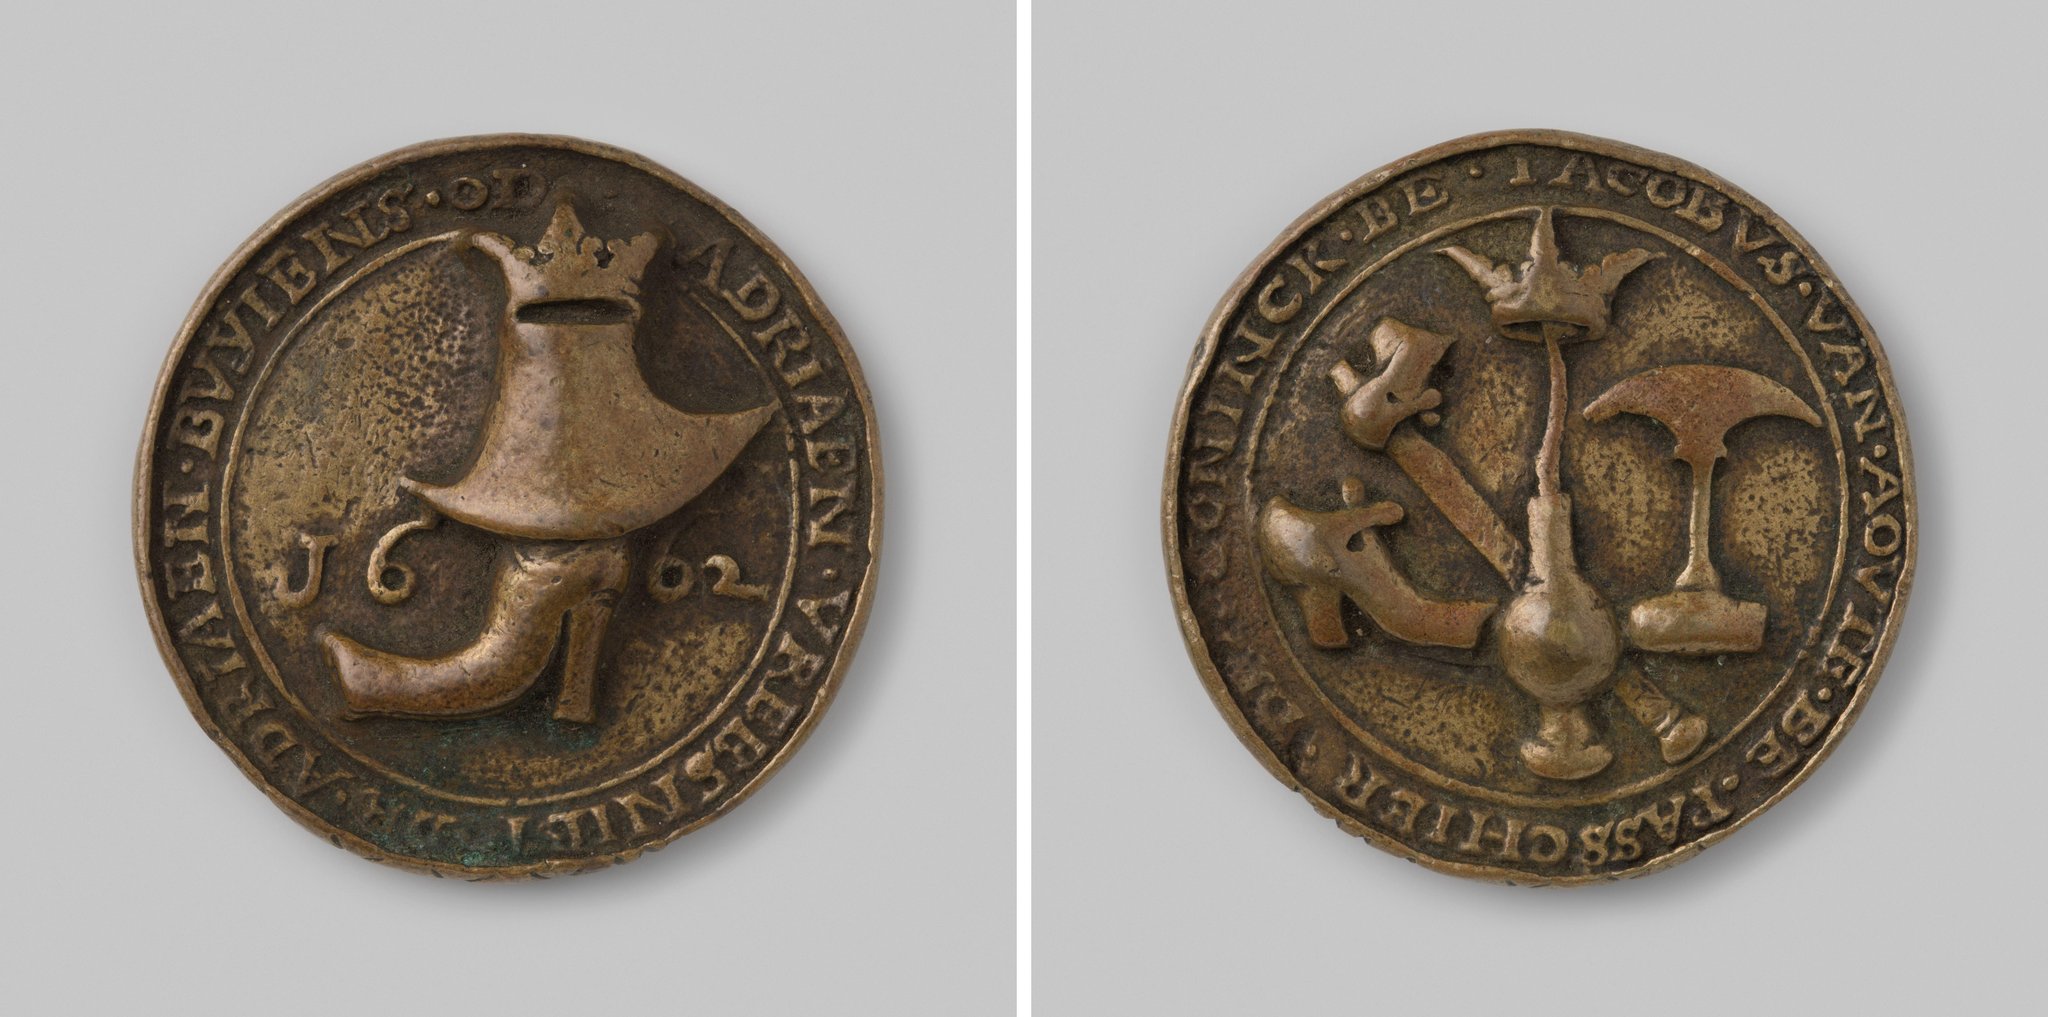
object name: history medal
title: Presentiepenning van het Schoenmakers-, huidenvetters- en leerverkopersgilde te Middelburg, 1662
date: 1662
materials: brass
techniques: casting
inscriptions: circumscription: ‘IACOBVS VAN AOVTE BE PASSCHIER DE CONINCK BE’, circumscription: ‘ADRIAEN VREESNIET DE ADRIAEN BVYTENS OD’, inscription: ‘XXXVIIII of XXXVIII’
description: Gegoten messing penning, op de voorzijde een gekroonde kaplaars en 1662, met omschrift, op de keerzijde een gekroonde els voor een schoen, een maatlat en een rondmes, met omschrift, op de rand gegraveerd het getal XXXVIIII [39]